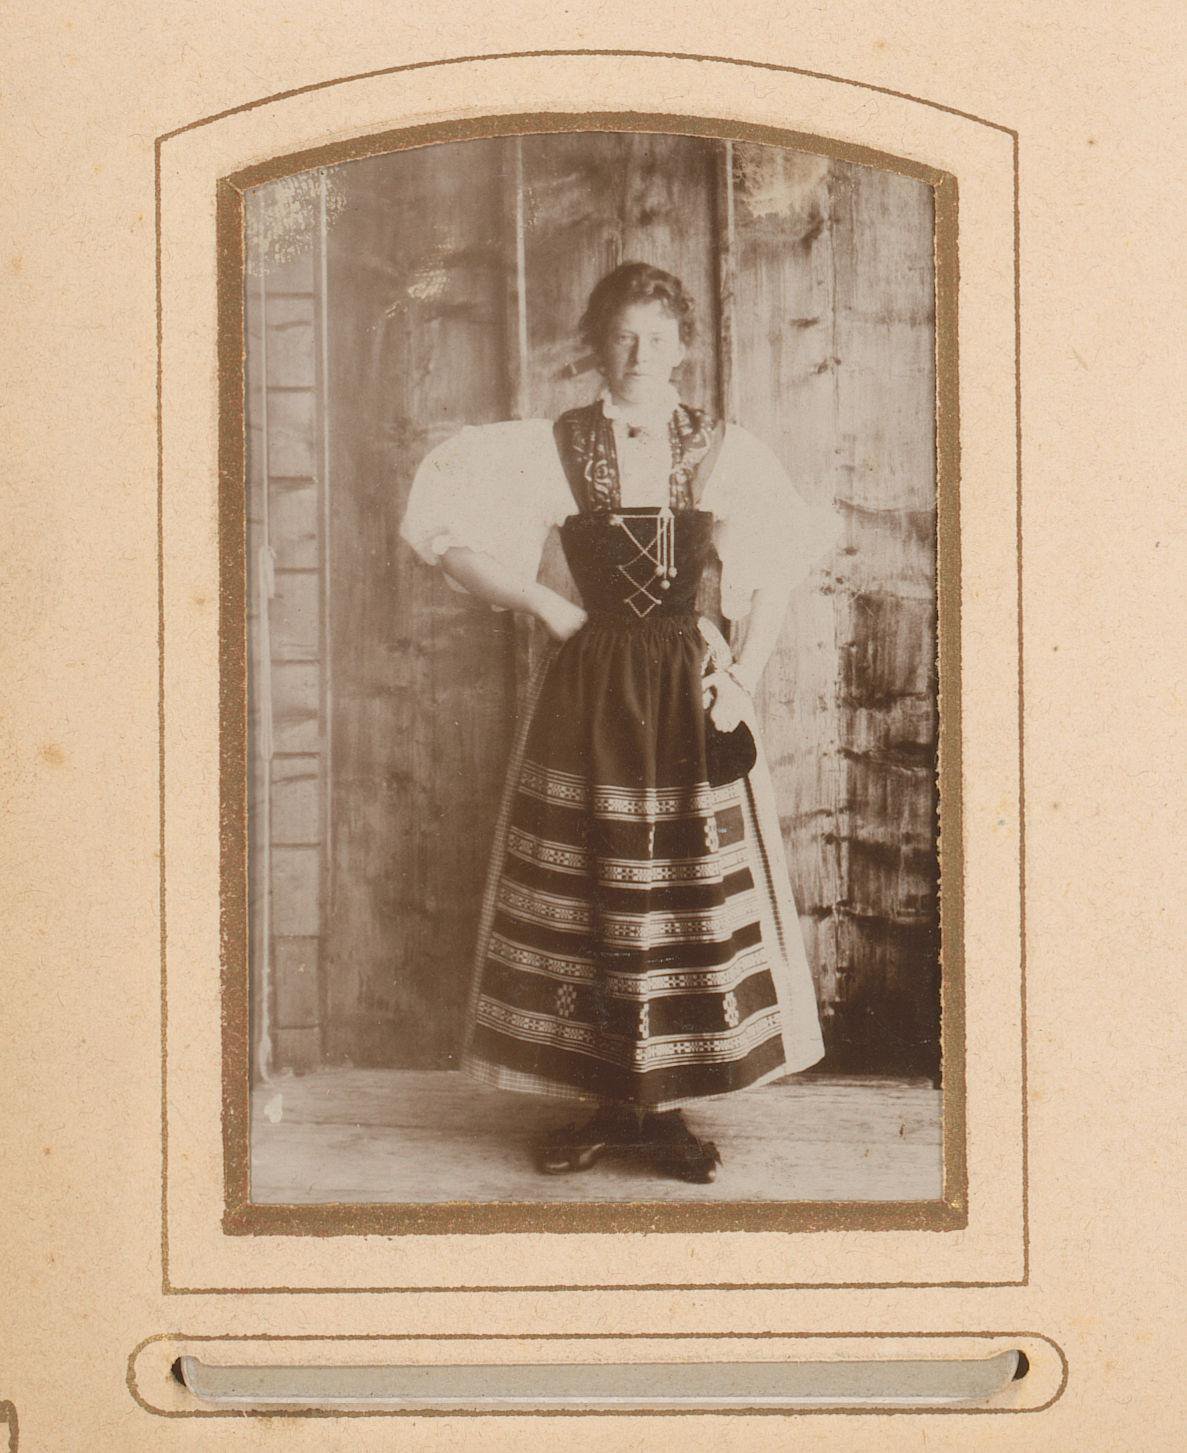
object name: album leaf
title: Portret van een vrouw in traditionele kleding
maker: Anonymous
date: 1880-1910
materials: cardboard, photographic support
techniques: collodion silver print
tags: historical persons - bb - woman, folk costume, regional costume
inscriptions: inscription: ‘Fritz Küken/ Bielefeld’